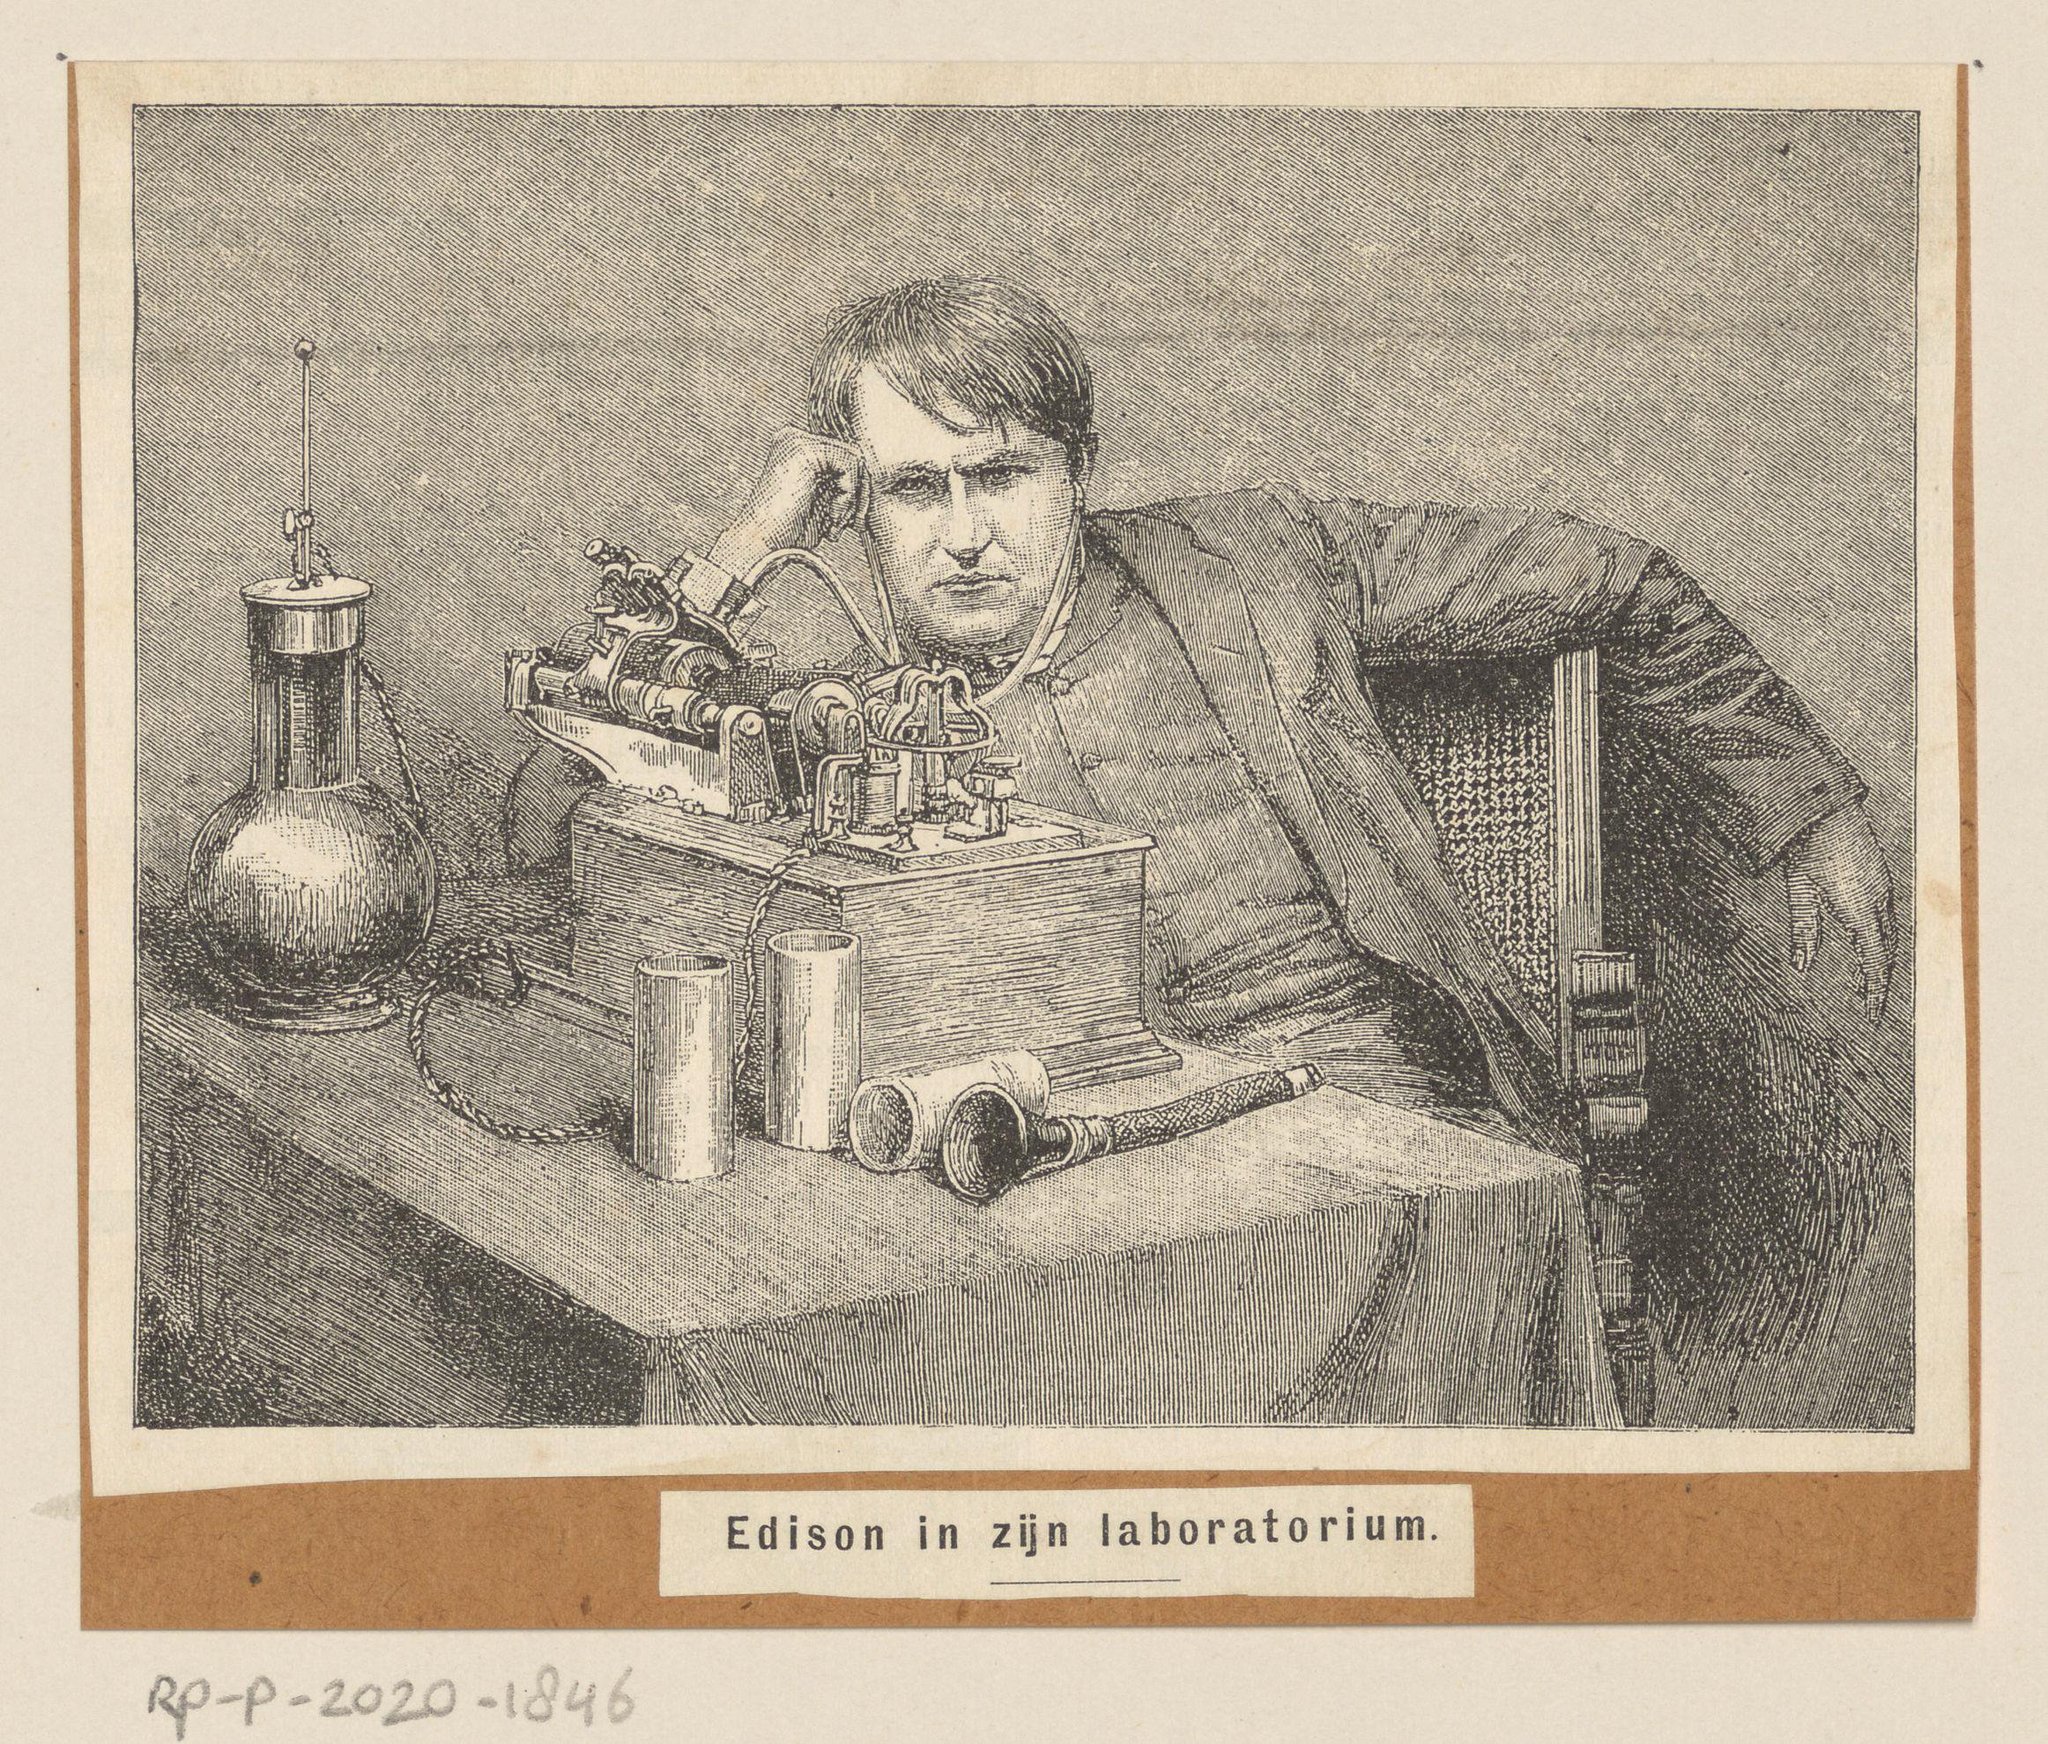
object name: print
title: Edison in zijn laboratorium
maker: Anonymous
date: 1870-1900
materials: paper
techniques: engraving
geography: netherlands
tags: laboratory (+ scholar, scientist (at work)), historical persons